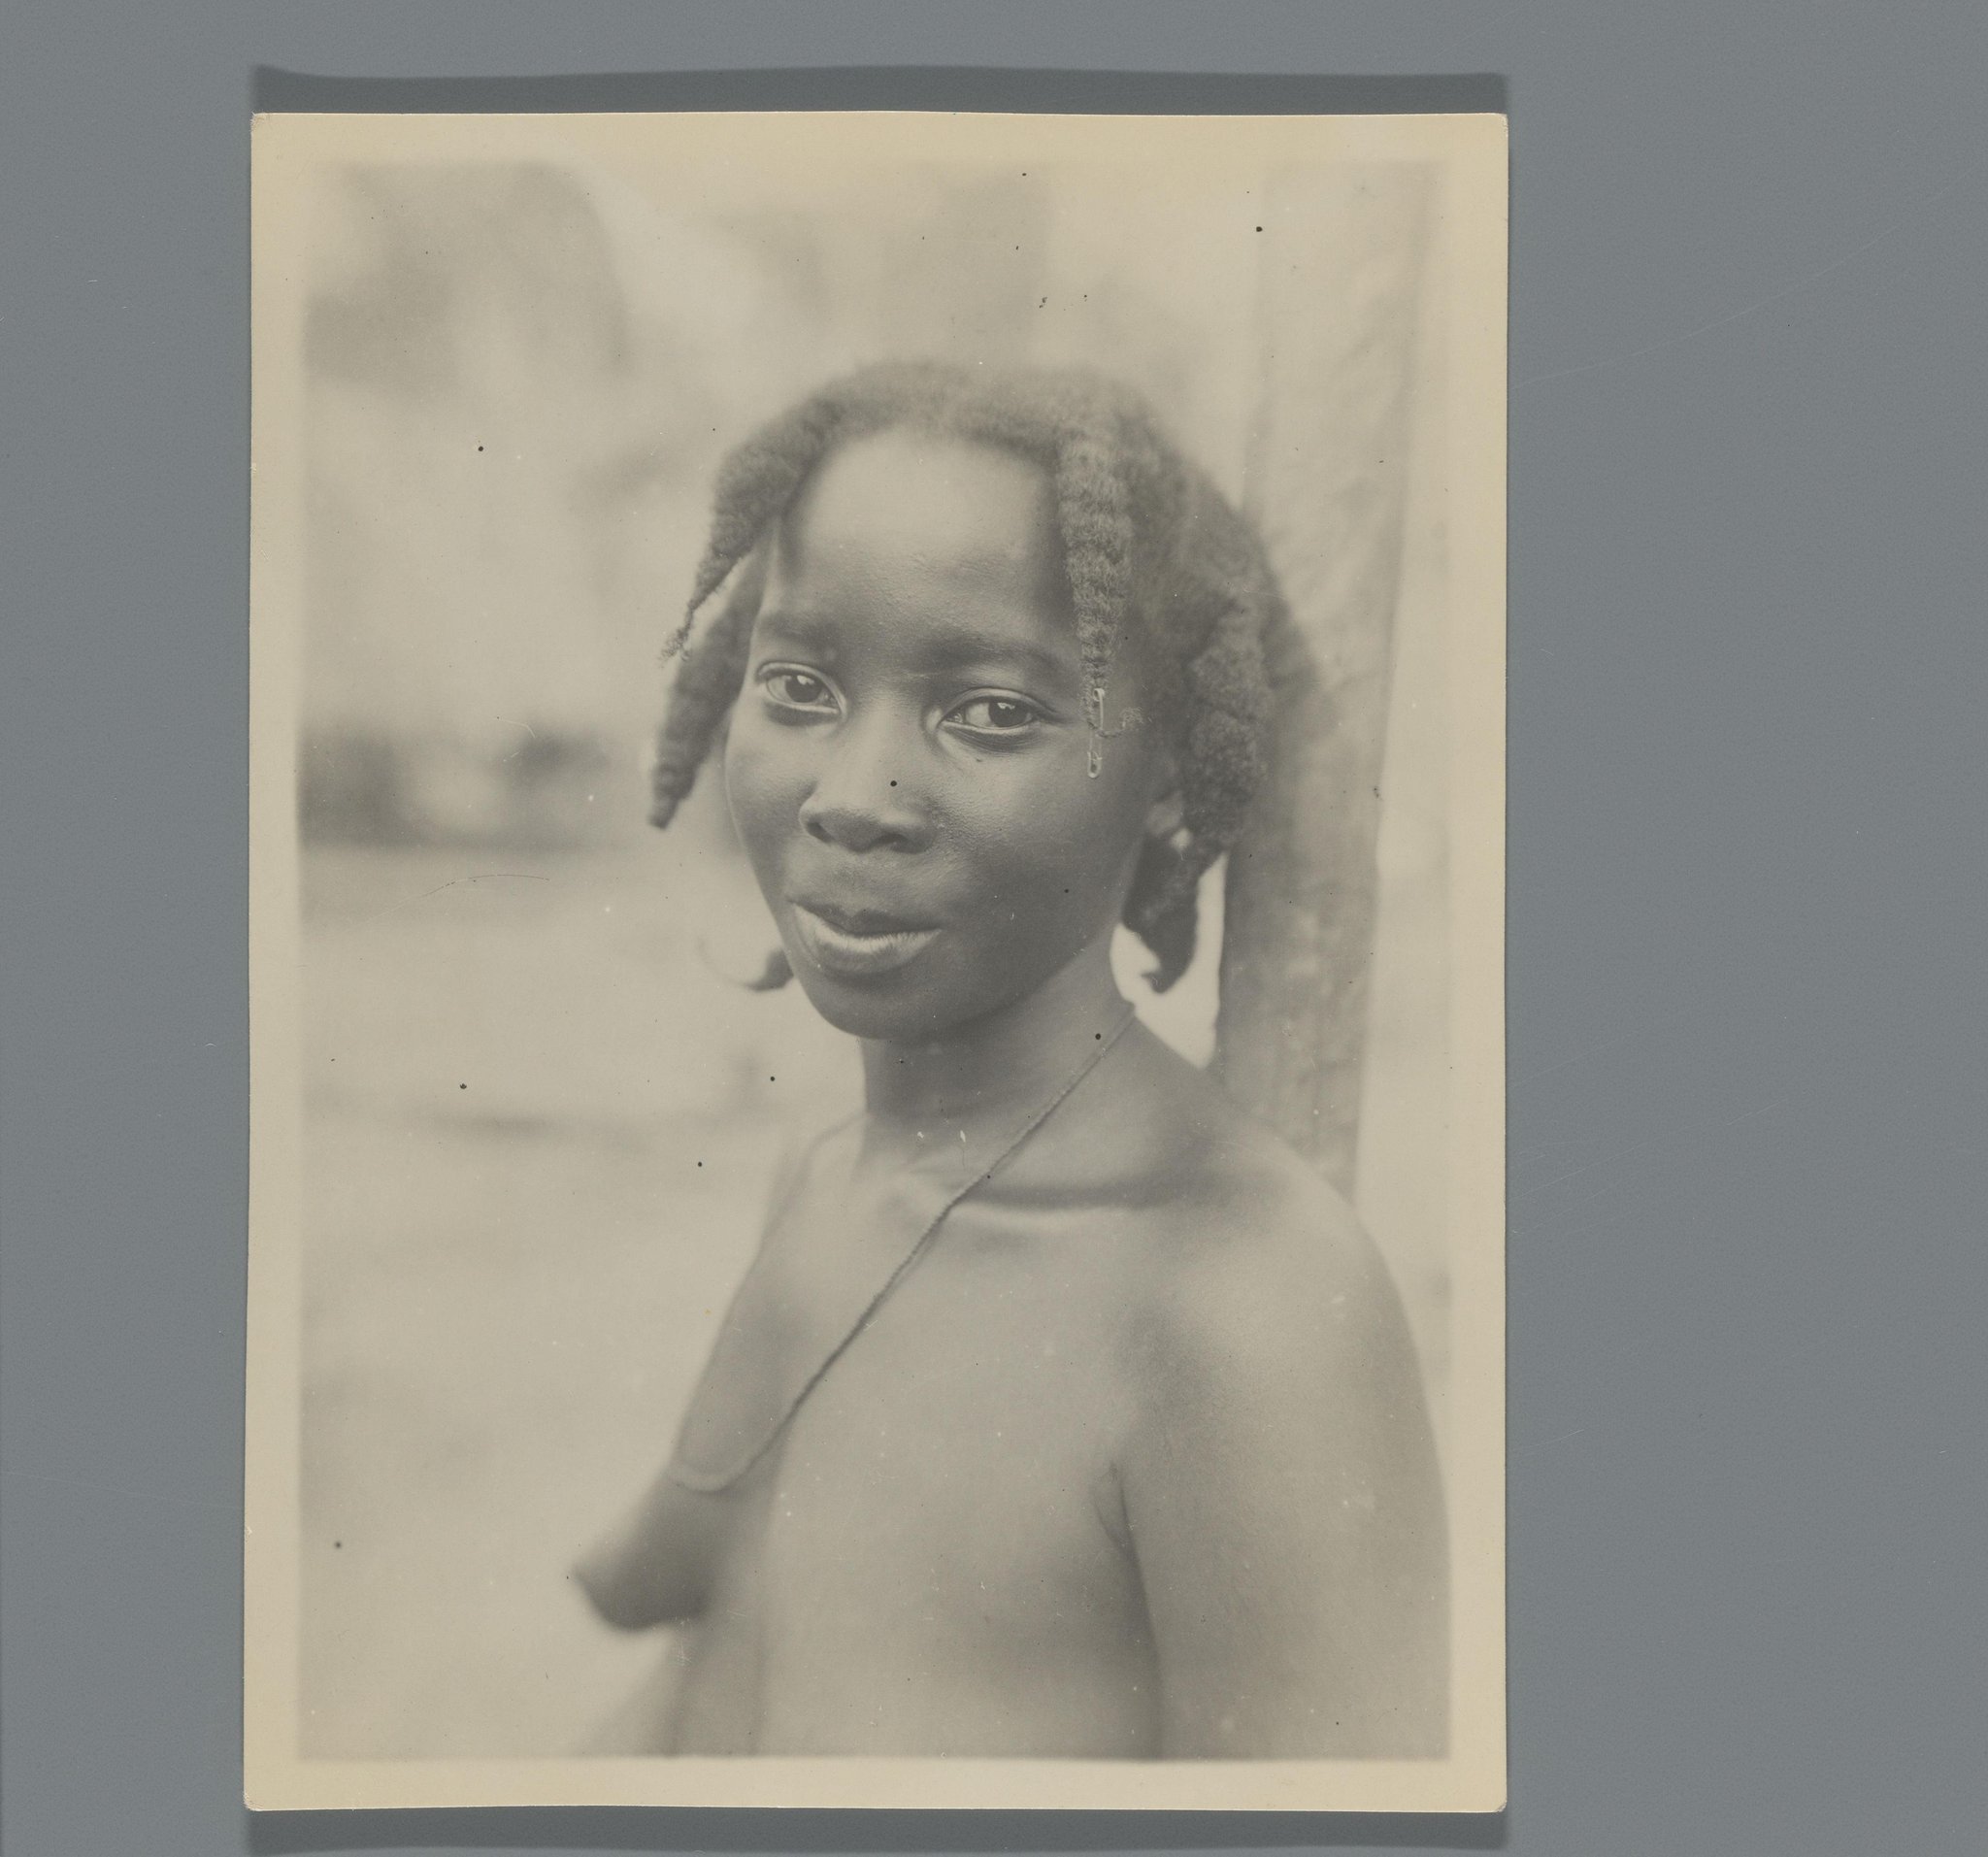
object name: photograph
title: Surinaams meisje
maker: Anonymous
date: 1925-1927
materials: photographic support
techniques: photography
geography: suriname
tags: jetten, familie, moengo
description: Surinaams meisje. Onderdeel van het ensemble met foto's van de familie van ingenieur Jetten in de mijnbouwstad Moengo in Suriname.